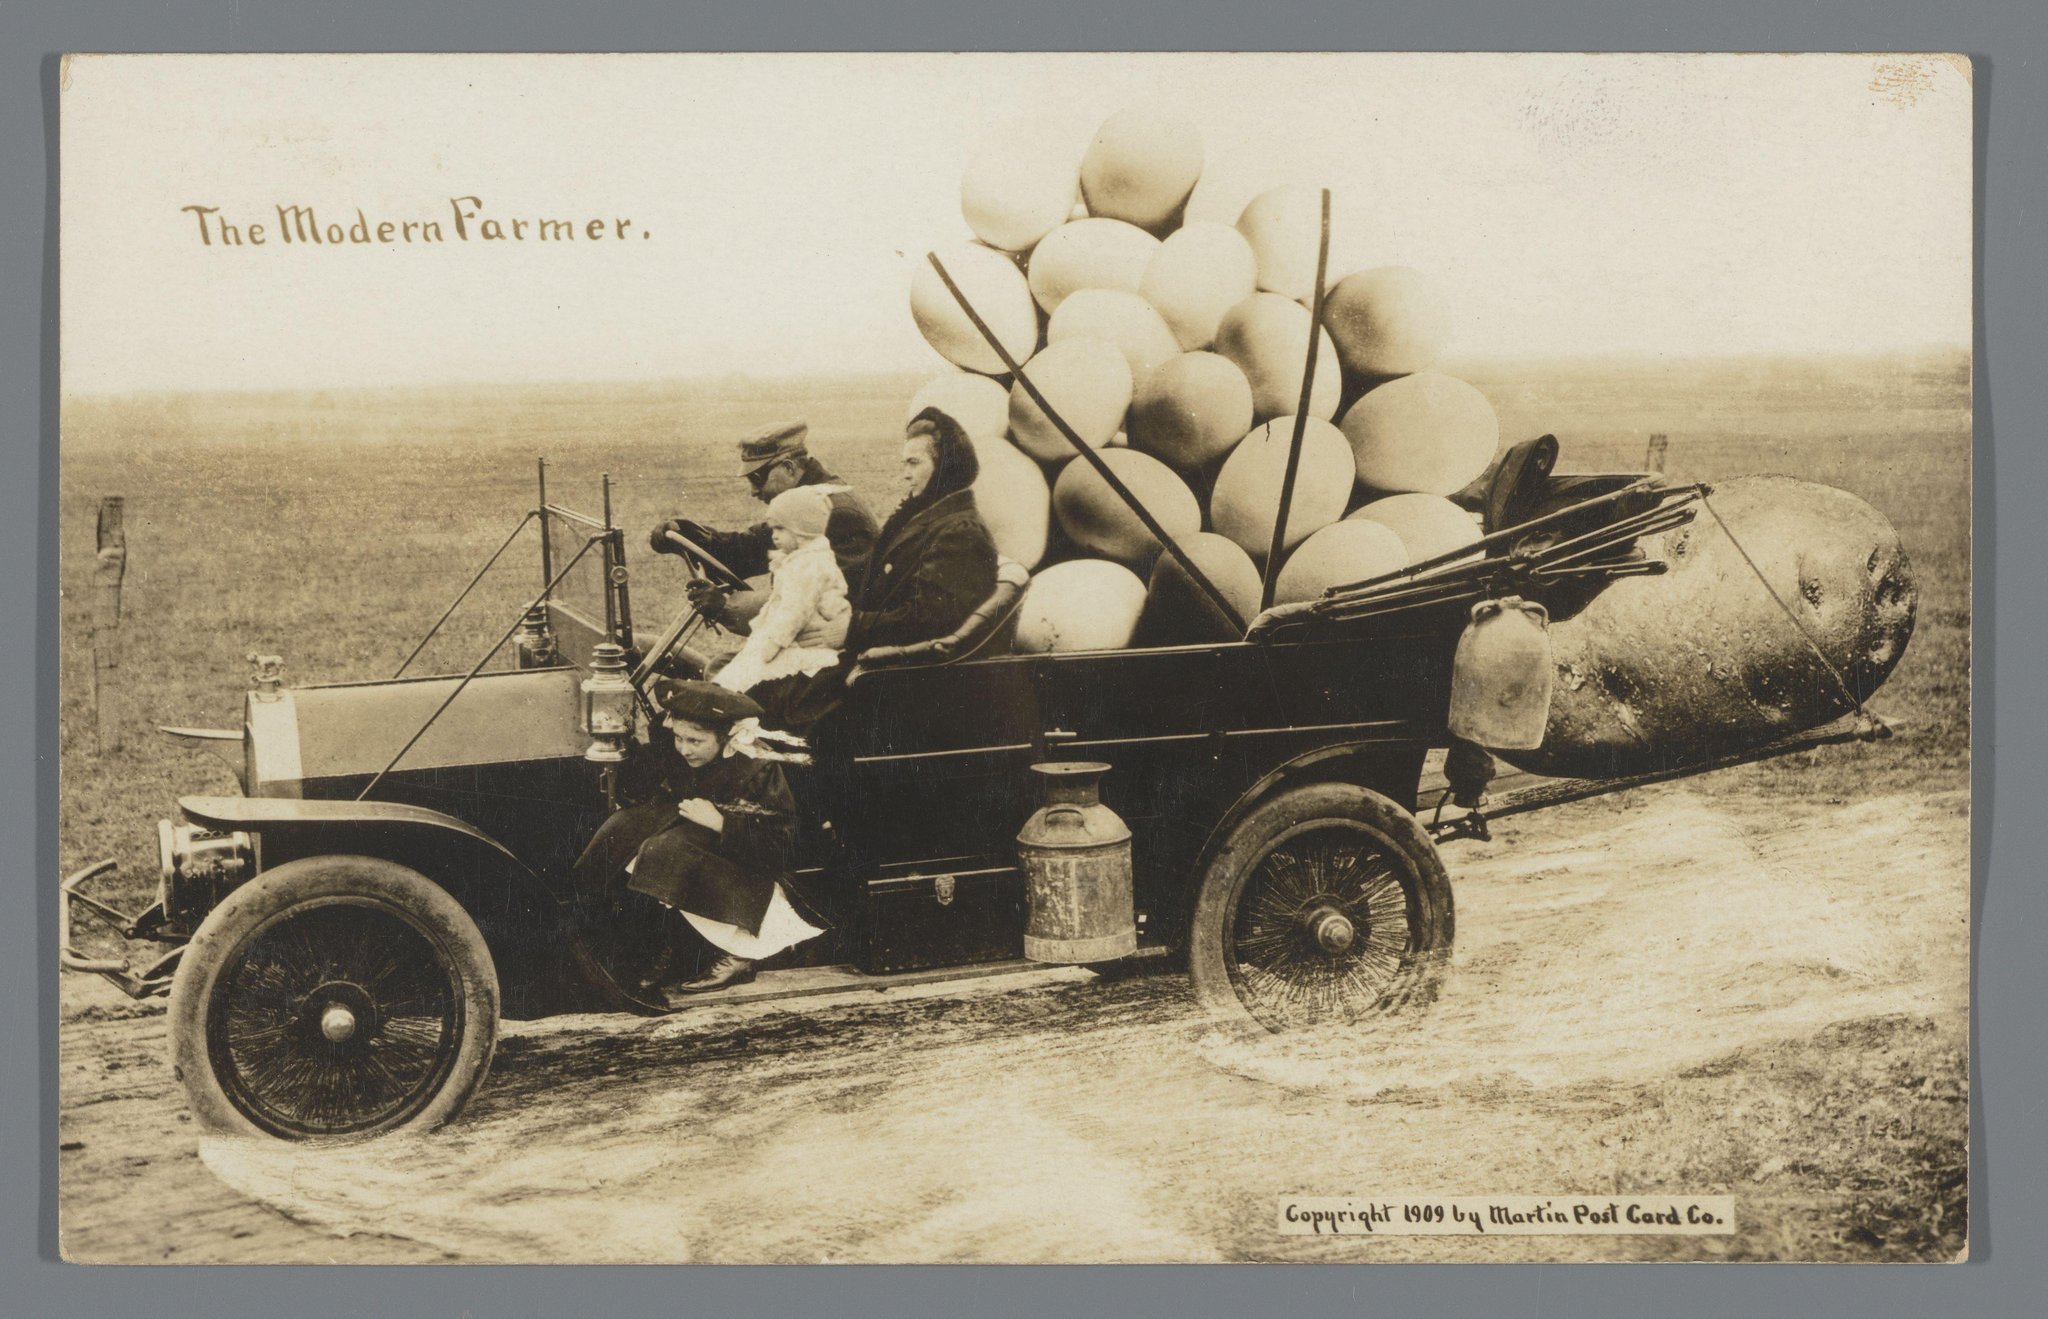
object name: ansichtkaart, prentbriefkaart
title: Prentbriefkaart met auto met vier mensen en een stel reusachtige eieren en een reusachtige aardappel aan de achterzijde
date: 1909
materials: photographic support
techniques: gelatin silver print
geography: united states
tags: united states of america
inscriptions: inscription: ‘PUBLISHED BY / THE NORTH AMERICAN POST CARD CO. / KANSAS CITY, U. S. A.’, inscription: ‘The Modern Farmer. / Copyright 1909 by Martin Post Card Co.’